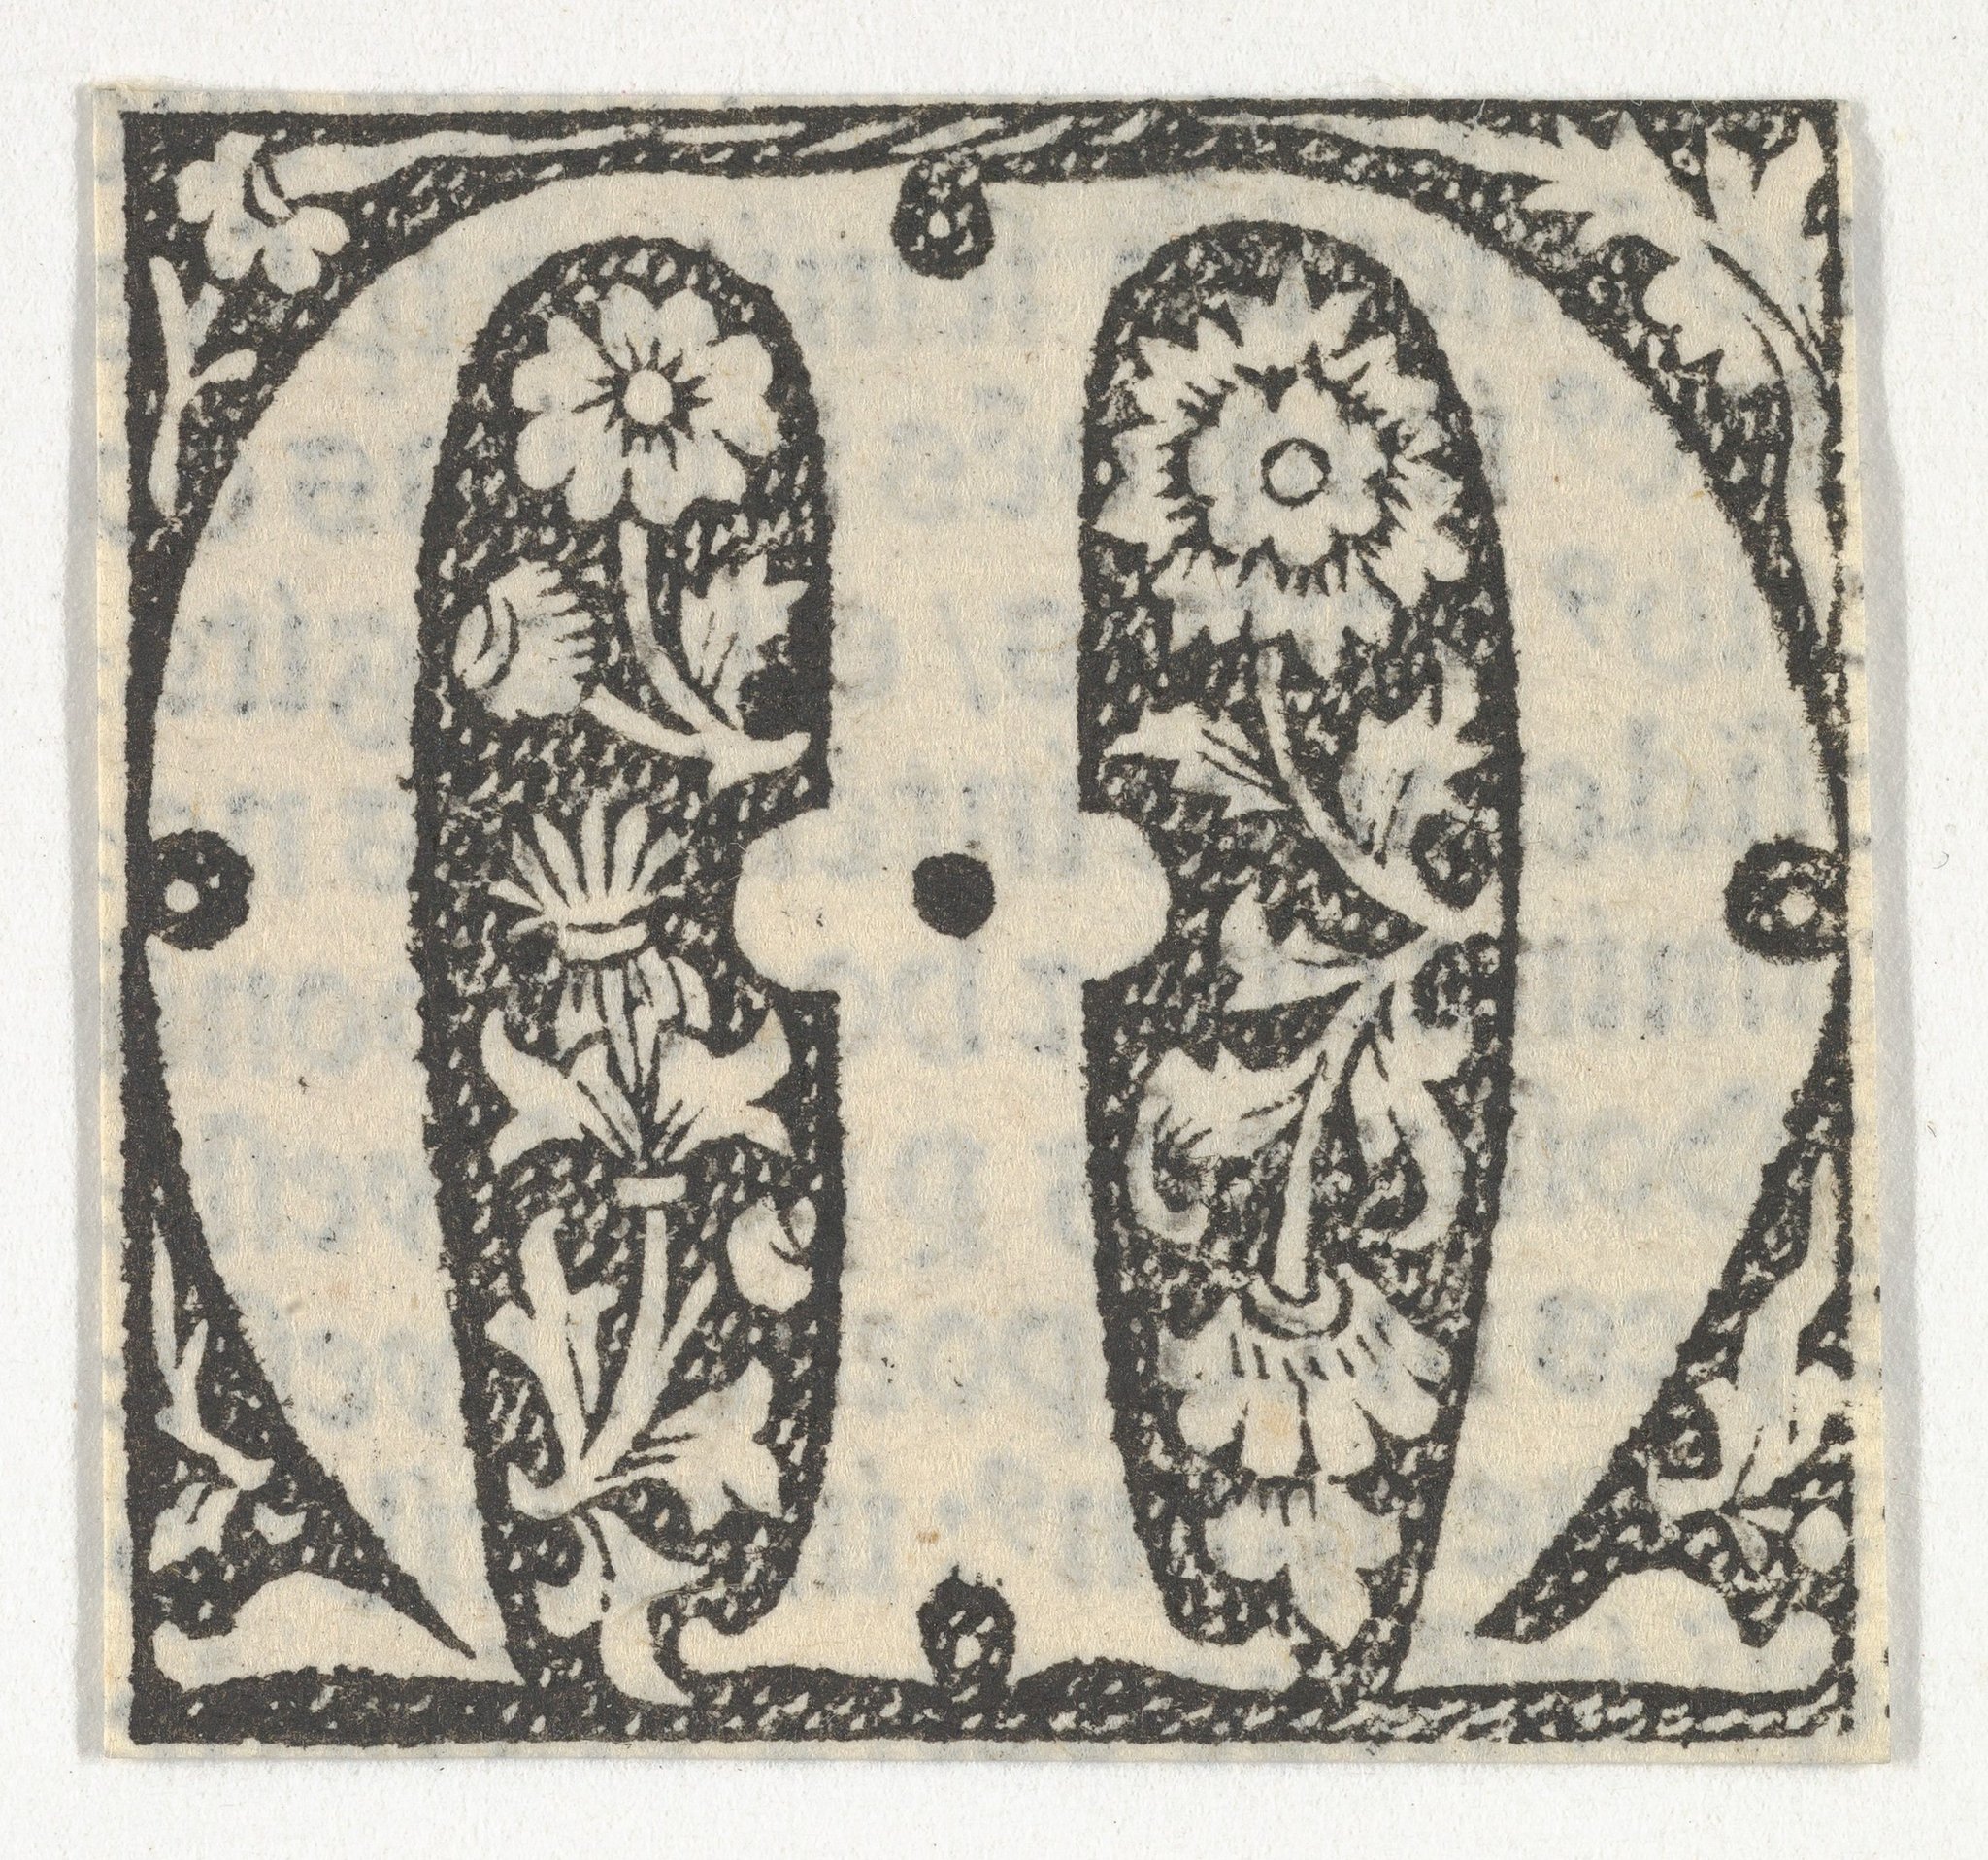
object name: print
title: Decorated Roman alphabet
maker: anonymous, french, 15th century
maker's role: artist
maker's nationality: french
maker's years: 1400-1500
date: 1499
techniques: woodcut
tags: flowers